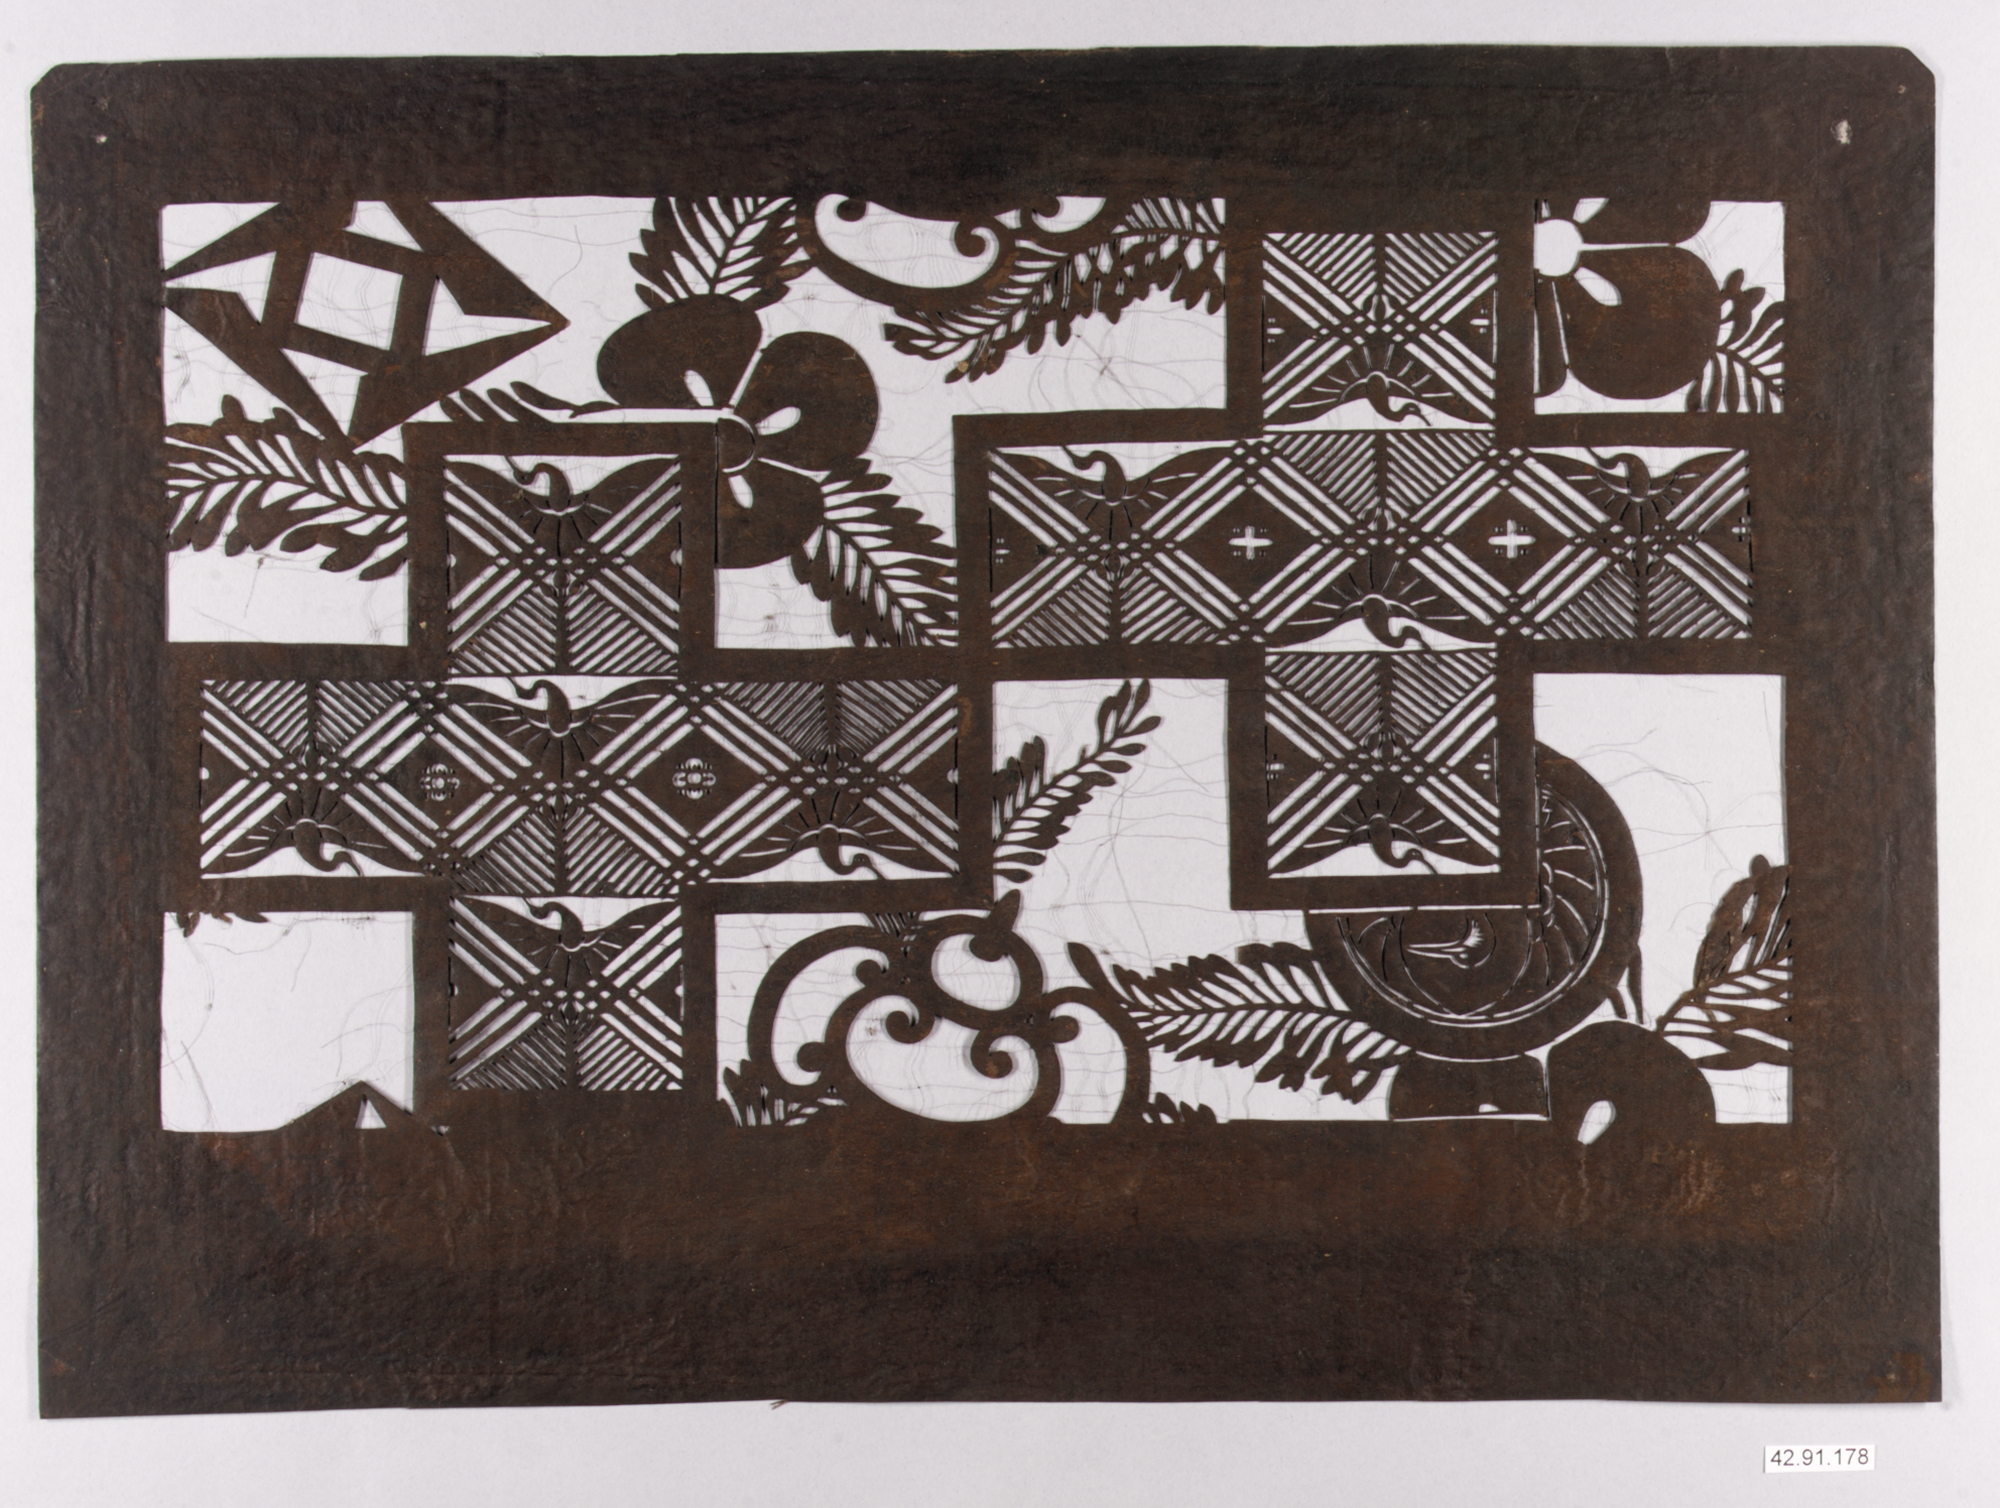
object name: stencil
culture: japanese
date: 1801-1900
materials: paper